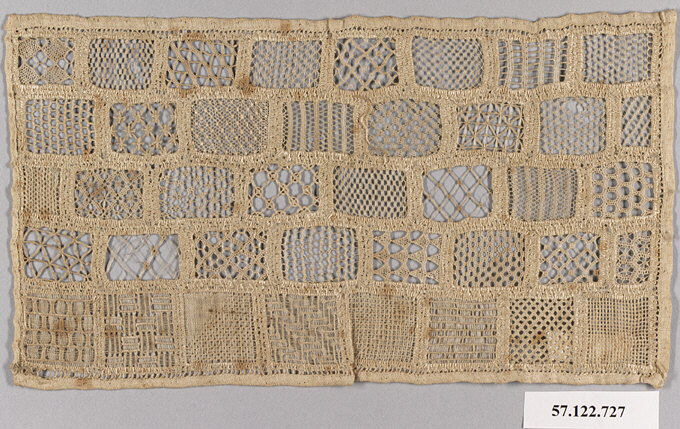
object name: sampler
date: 1801-1900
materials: linen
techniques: embroidery, lace